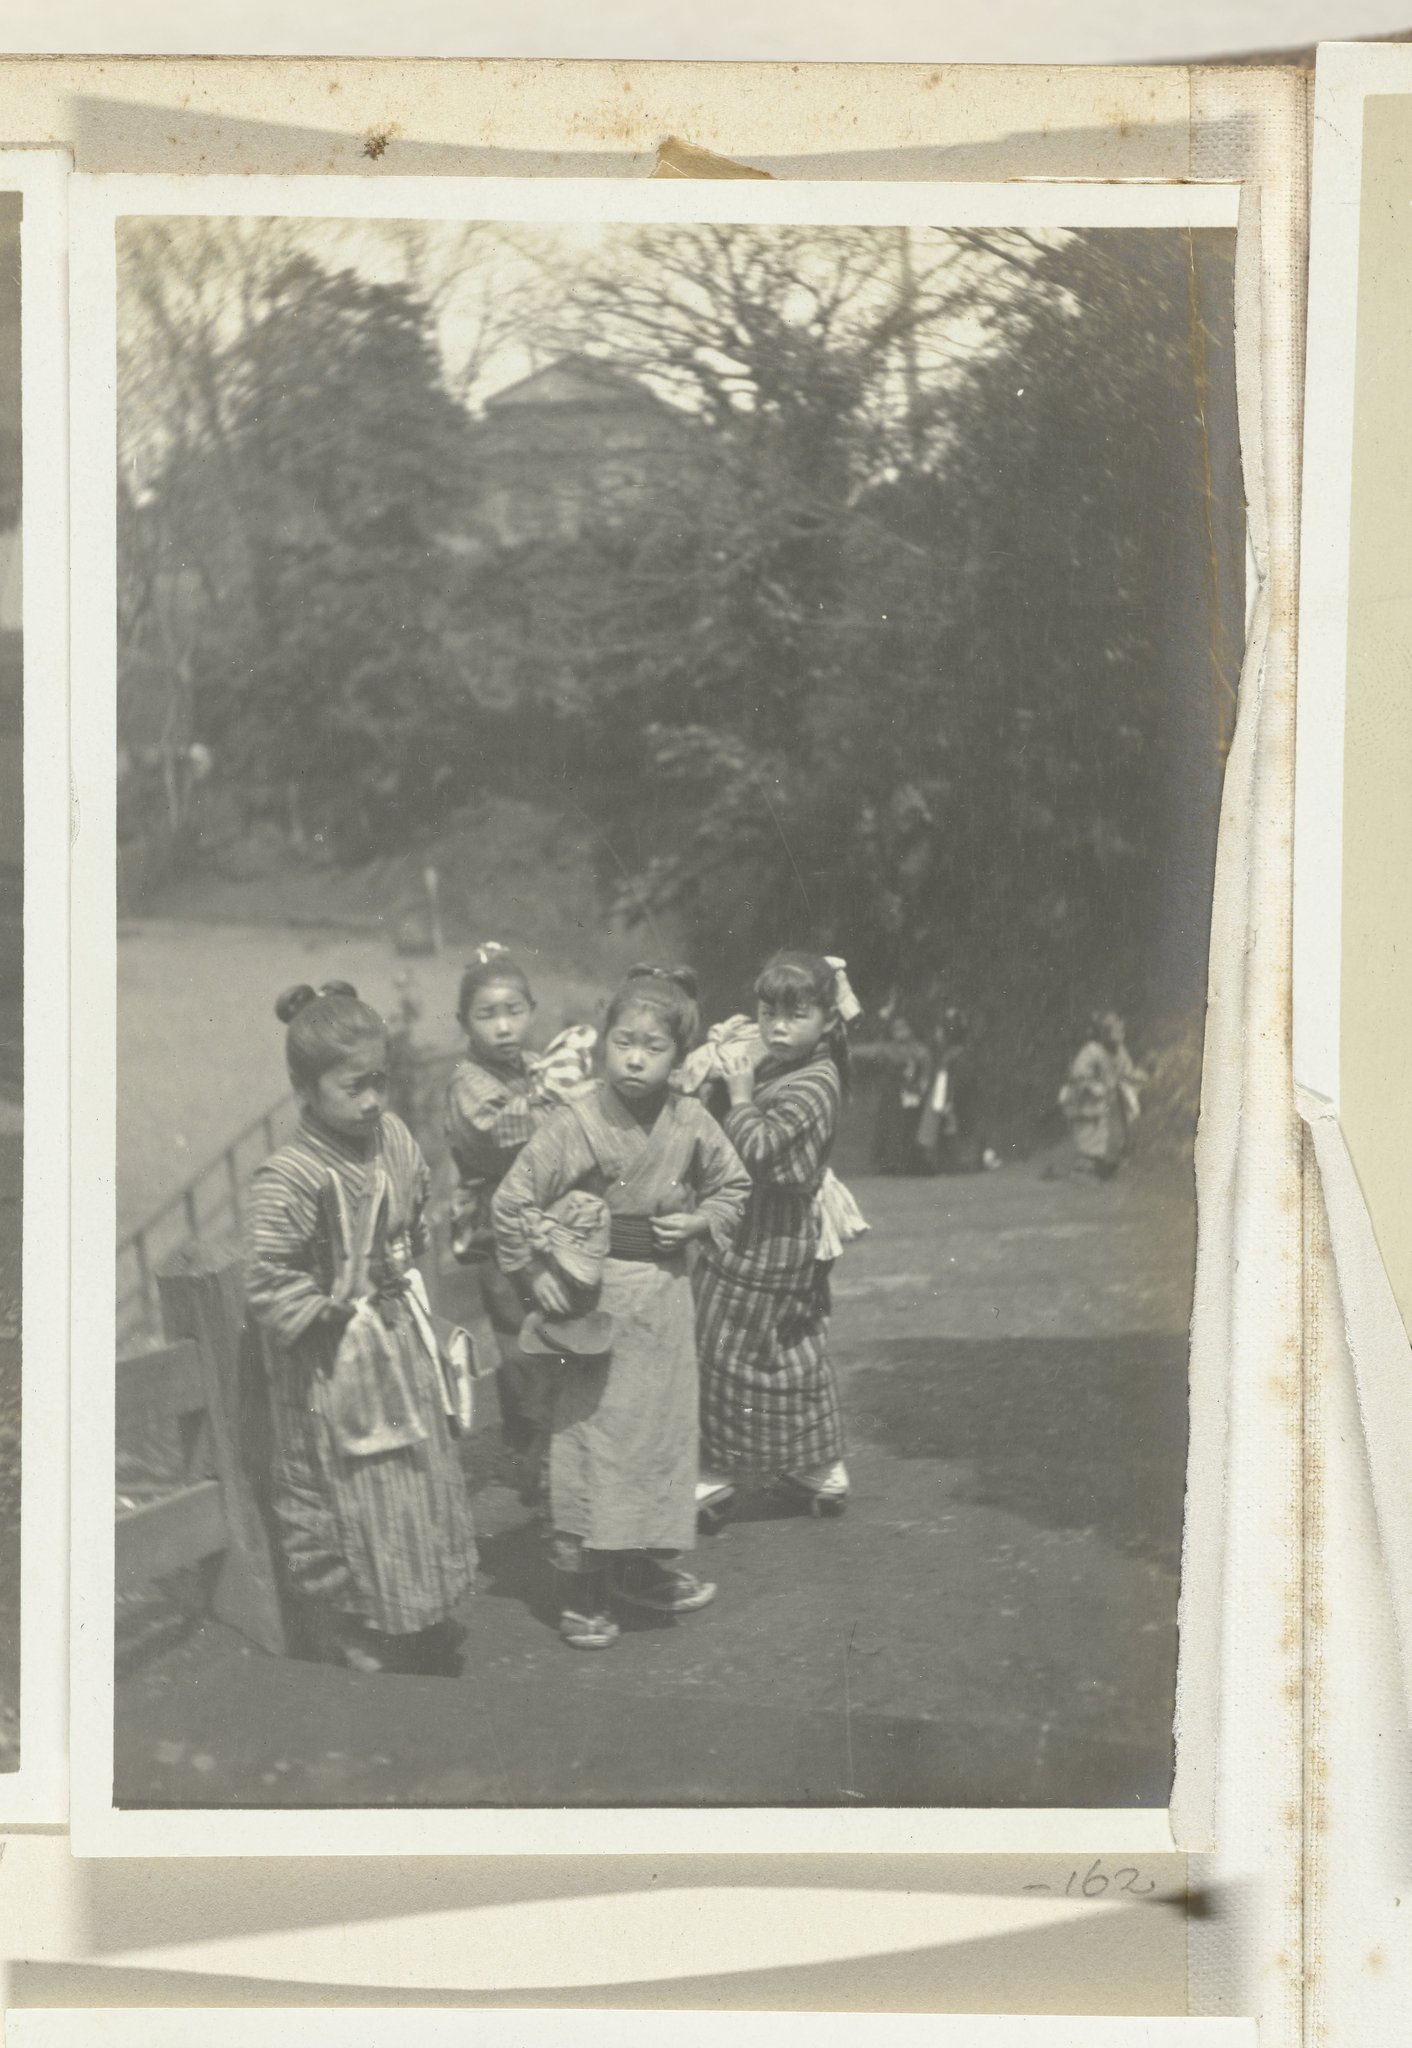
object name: photograph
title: Japanse meisjes in kimono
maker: geldolph adriaan kessler (dolph)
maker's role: fotograaf, industrieel, voetballer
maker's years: 1884-1945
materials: cardboard, photographic support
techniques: gelatin silver print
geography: japan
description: Onderdeel van het fotoalbum van Dolph Kessler met opnamen die hij maakte tijdens zijn verblijf in Engeland en op een wereldreis die hij als secretaris van Henri Deterding (directeur Koninklijke Olie) ondernam naar Nederlands-Indië, Japan, China en de Verenigde Staten, tussen 1906 en 1908.